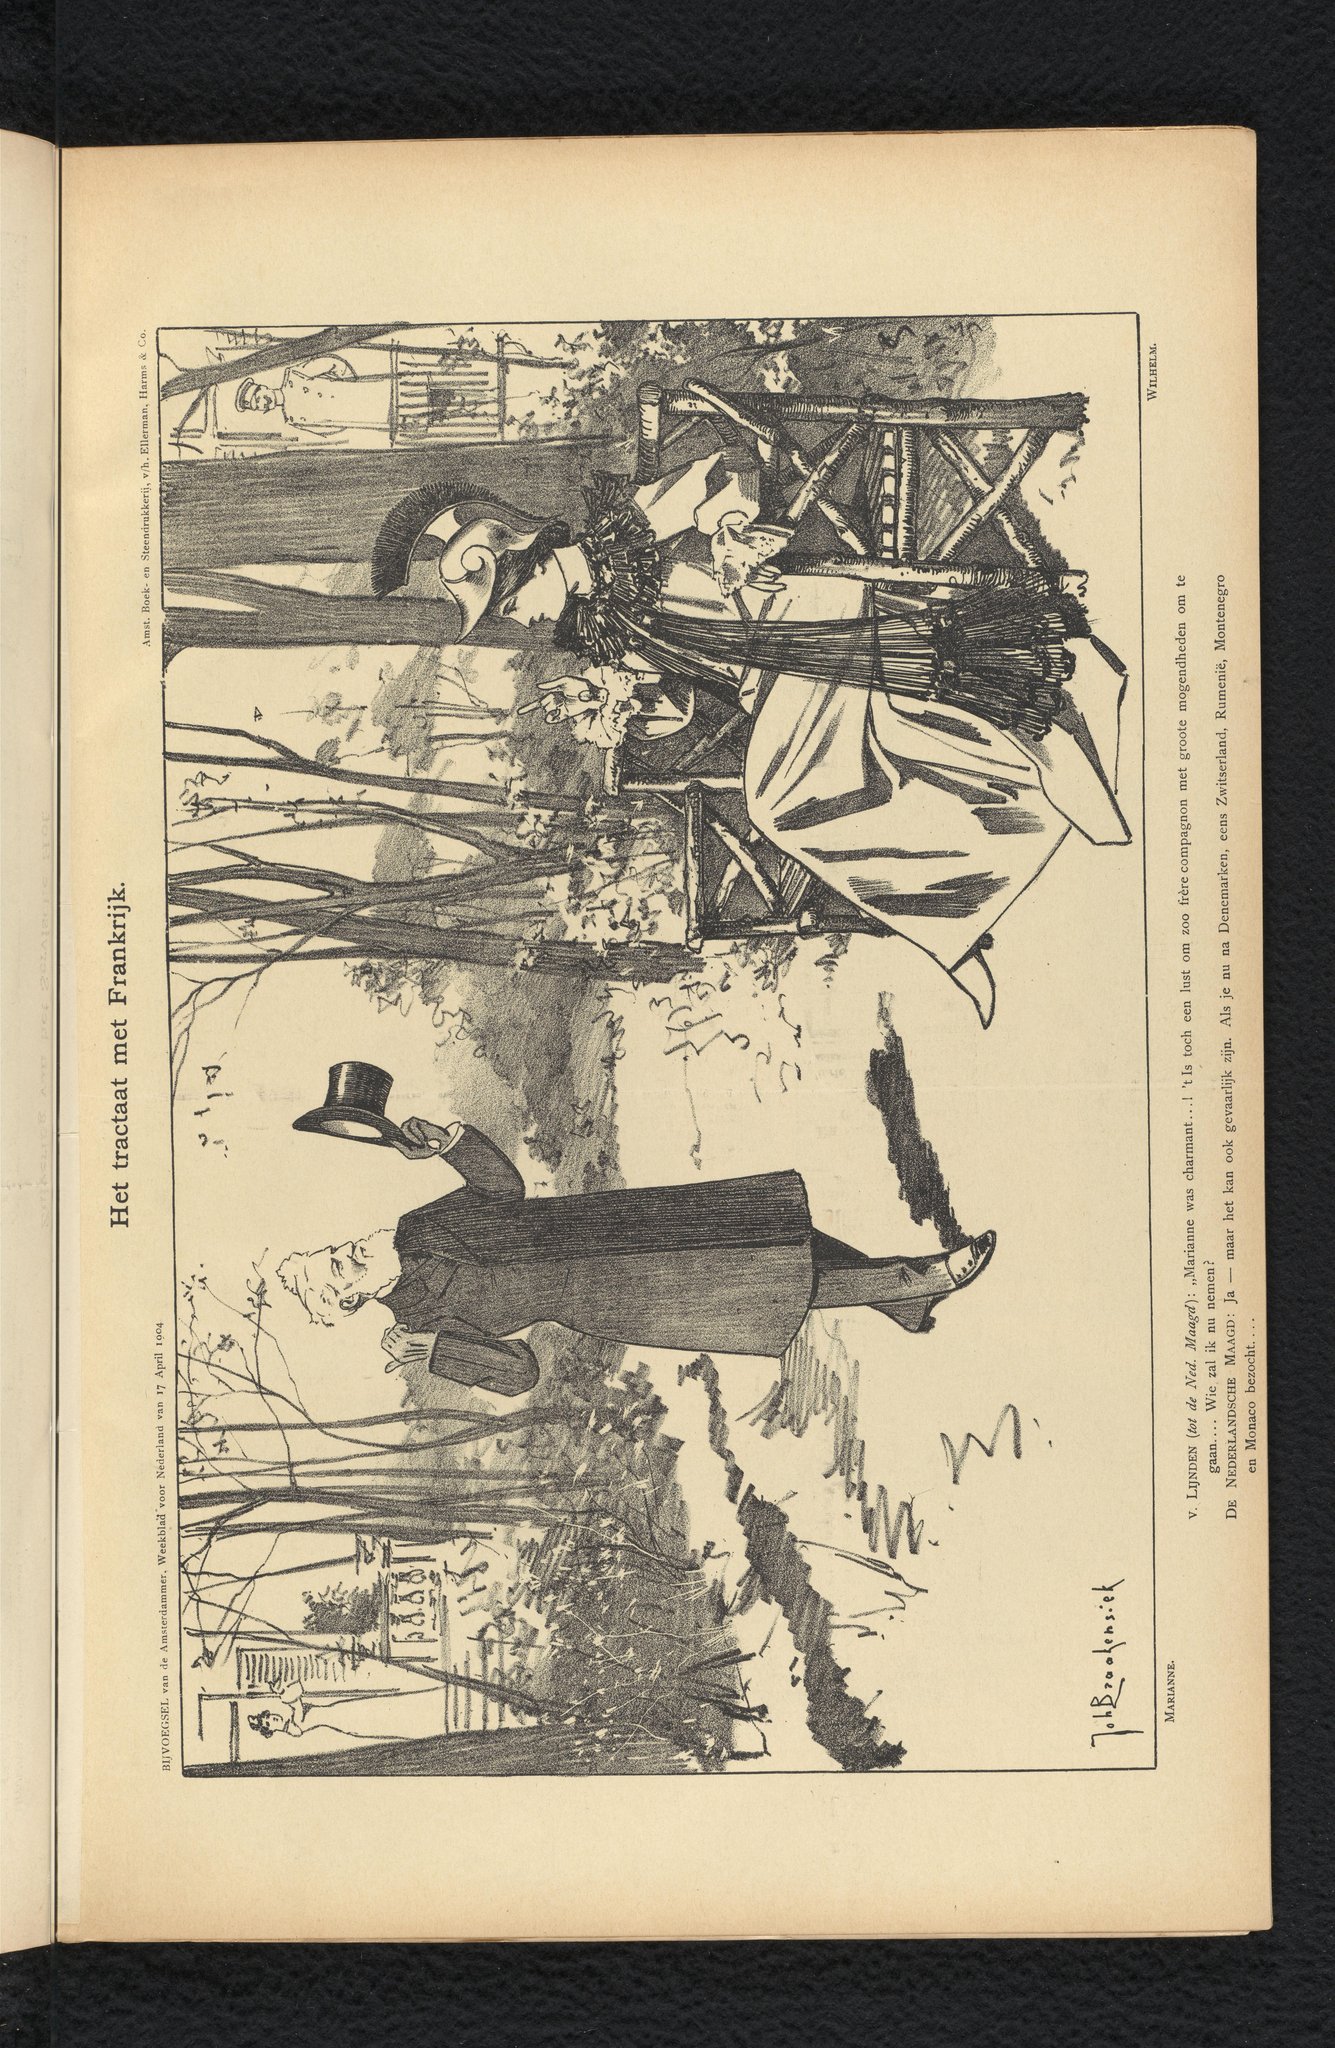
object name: cartoon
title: Het tractaat met Frankrijk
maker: johan braakensiek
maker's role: draughtsman, print maker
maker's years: 1858-1940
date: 1904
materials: paper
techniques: lithograph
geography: amsterdam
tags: personifications of countries, nations, states, districts, etc., political caricatures and satires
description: Minister van Buitenlandse Zaken Robert Melvil baron van Lynden sprekend met de Nederlandse Maagd op een bankje in de tuin, na een bezoek aan Marianne (Frankrijk).